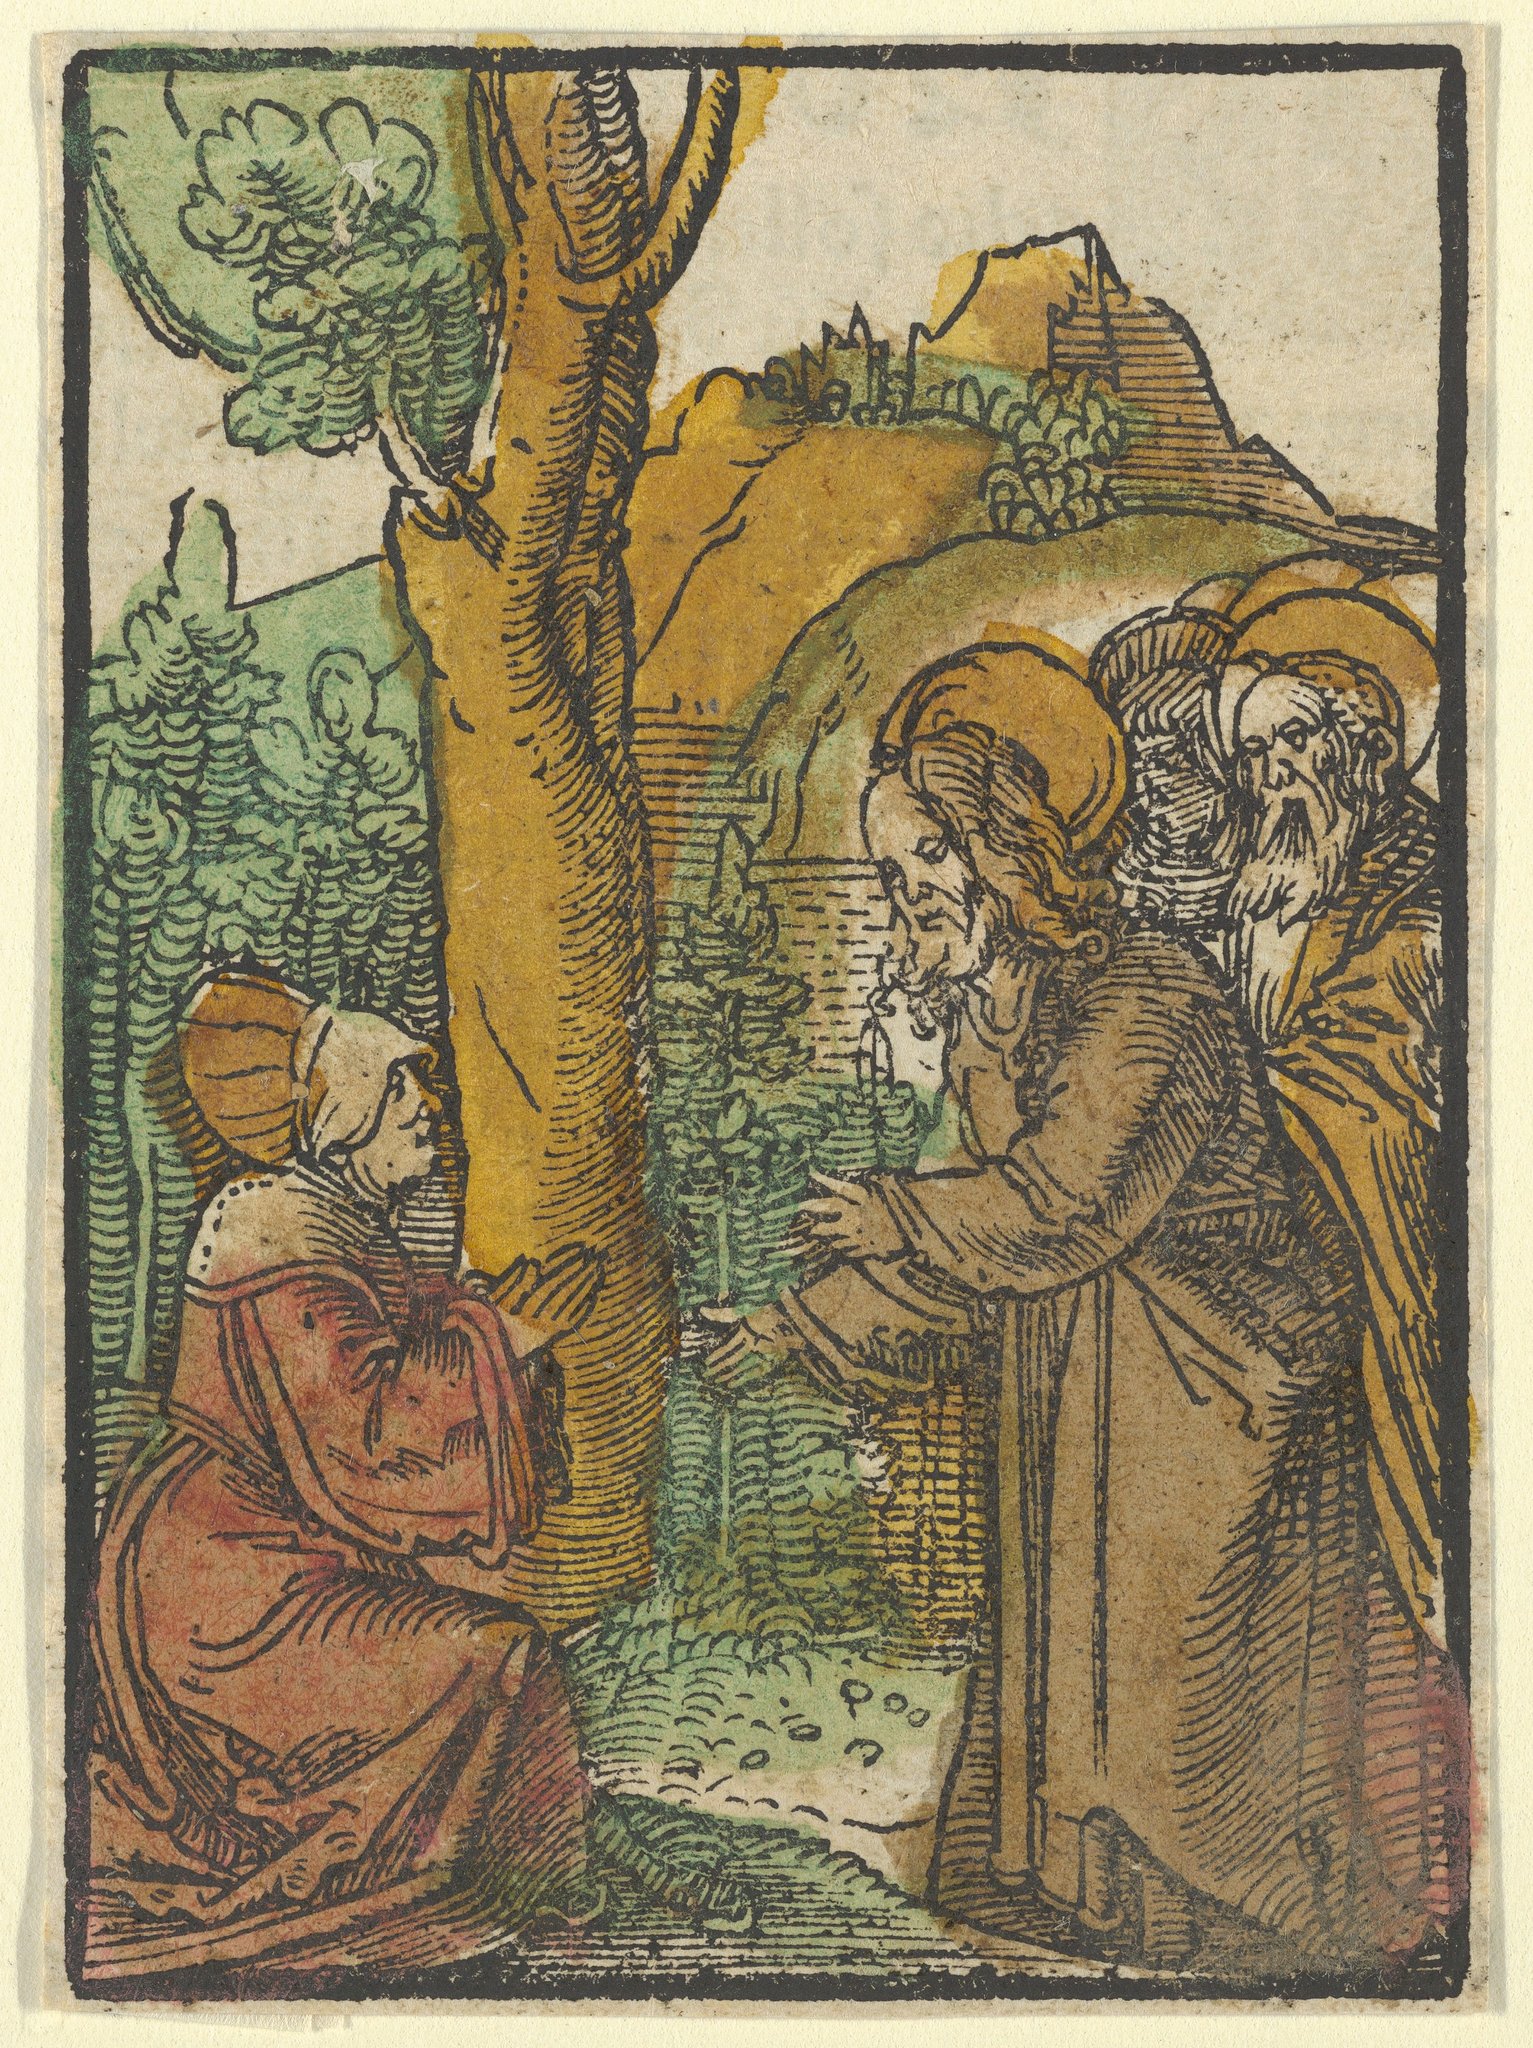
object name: print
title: Christ and the Woman of Canaan, from Das Plenarium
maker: hans schäufelein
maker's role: artist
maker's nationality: german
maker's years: 1480-1540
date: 1517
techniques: hand coloring, woodcut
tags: women,christ